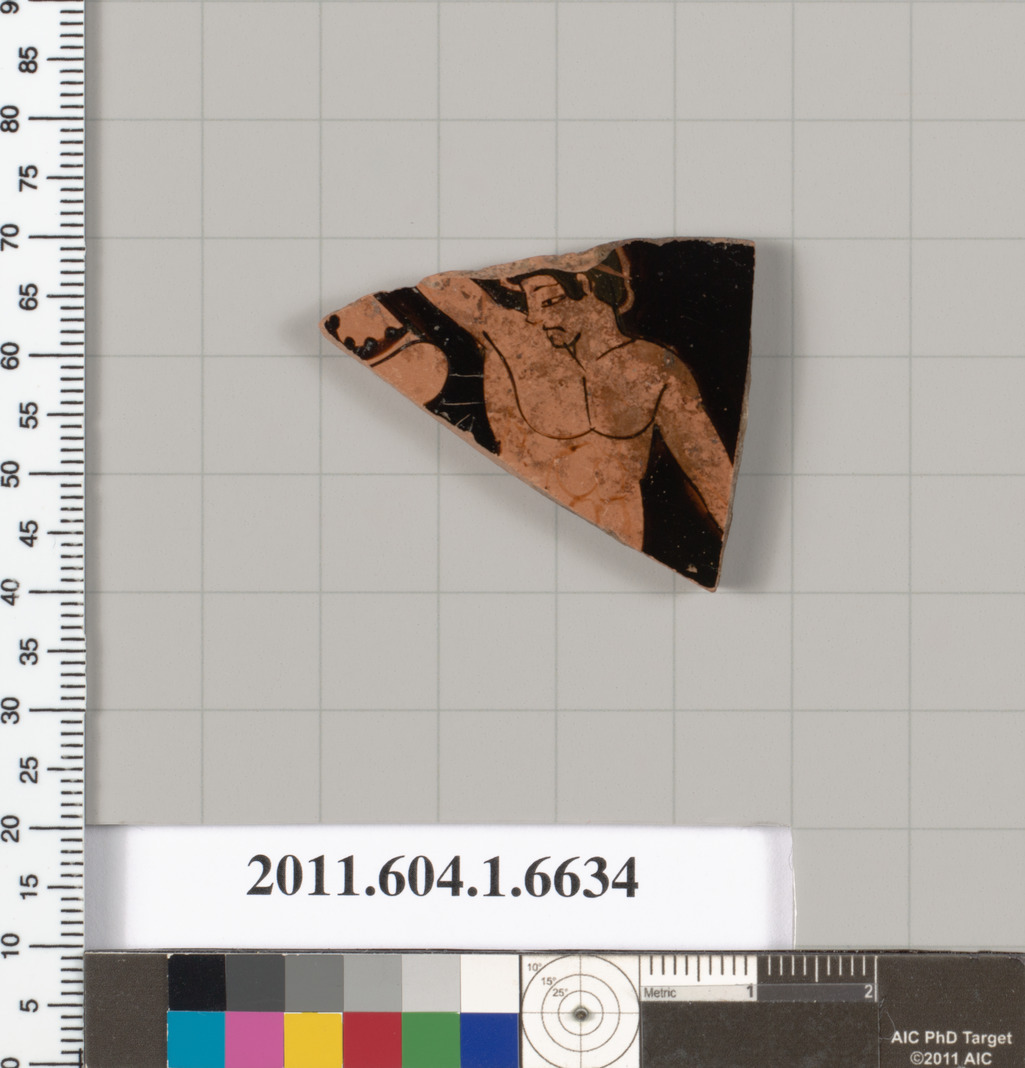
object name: kylix fragment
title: Terracotta fragment of a kylix (drinking cup)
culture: greek, attic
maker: brygos painter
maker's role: artist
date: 490-470 BCE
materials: terracotta